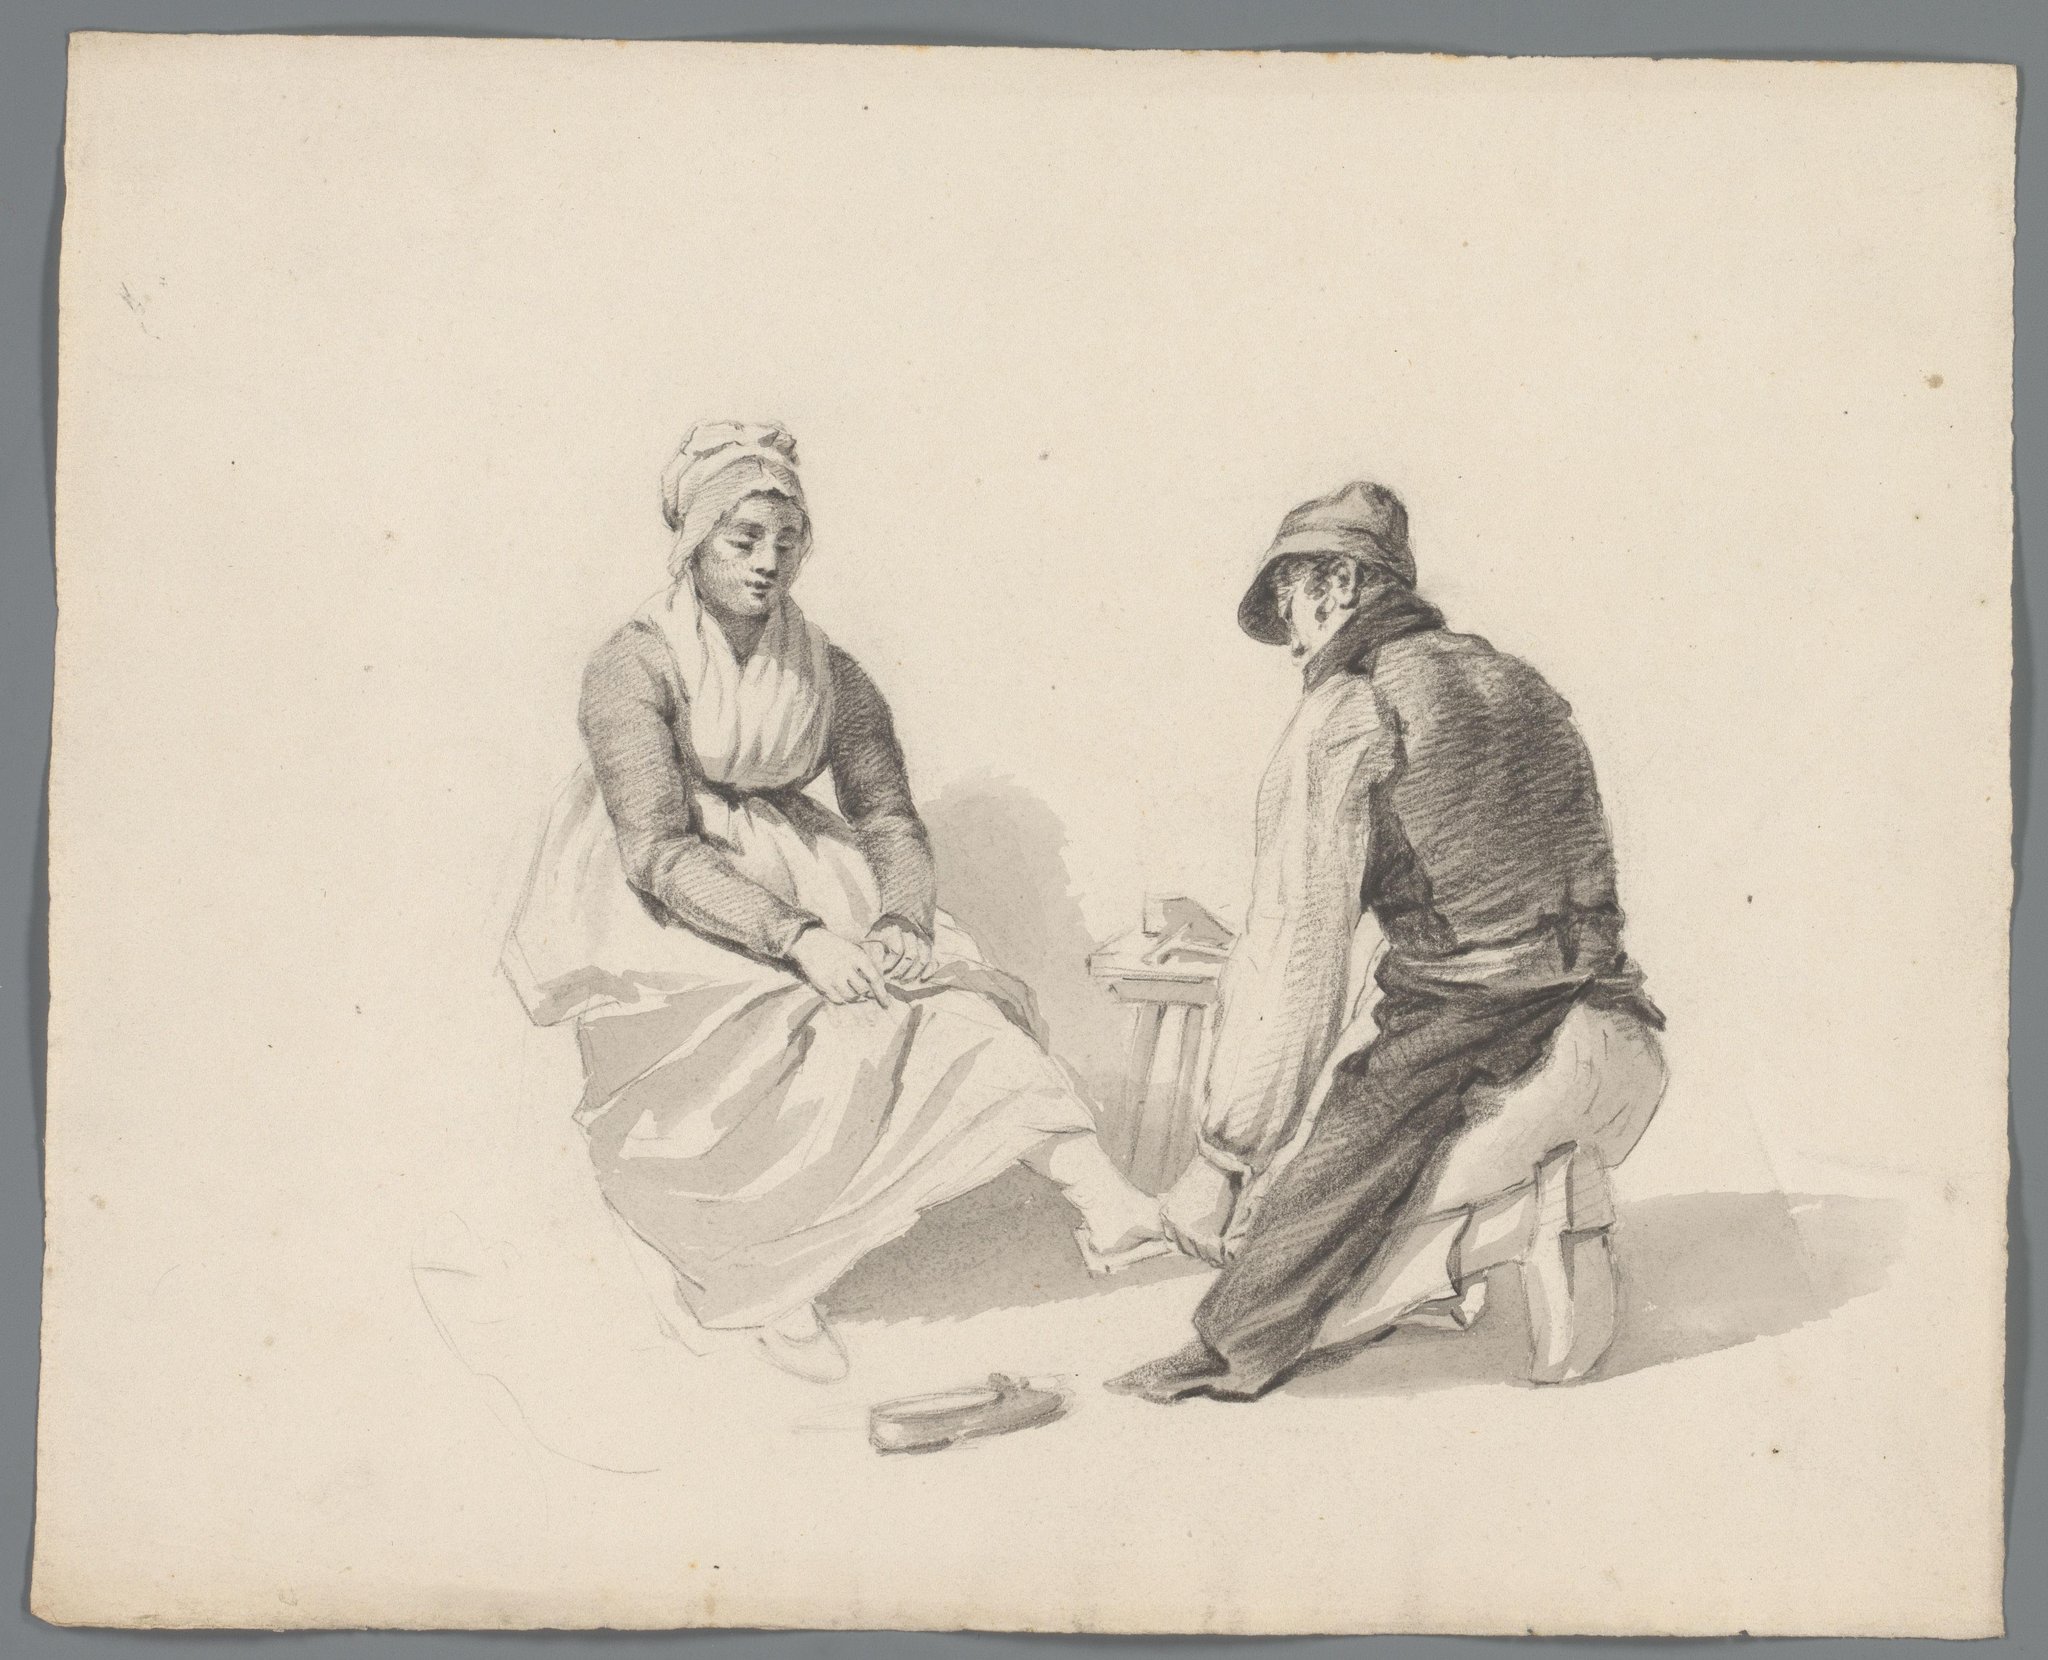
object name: drawing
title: Vrouw bij een schoenmaker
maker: Anonymous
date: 1820-1830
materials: chalk, paper, watercolor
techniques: brush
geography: the hague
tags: adult woman, shoe-maker, cobbler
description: Tekeningen waarschijnlijk ontstaan bij het Haagse kunstgenootschap ‘Tot Nut der Tekenkunst’, waar twee keer per week tekenavonden werden georganiseerd met geklede modellen.